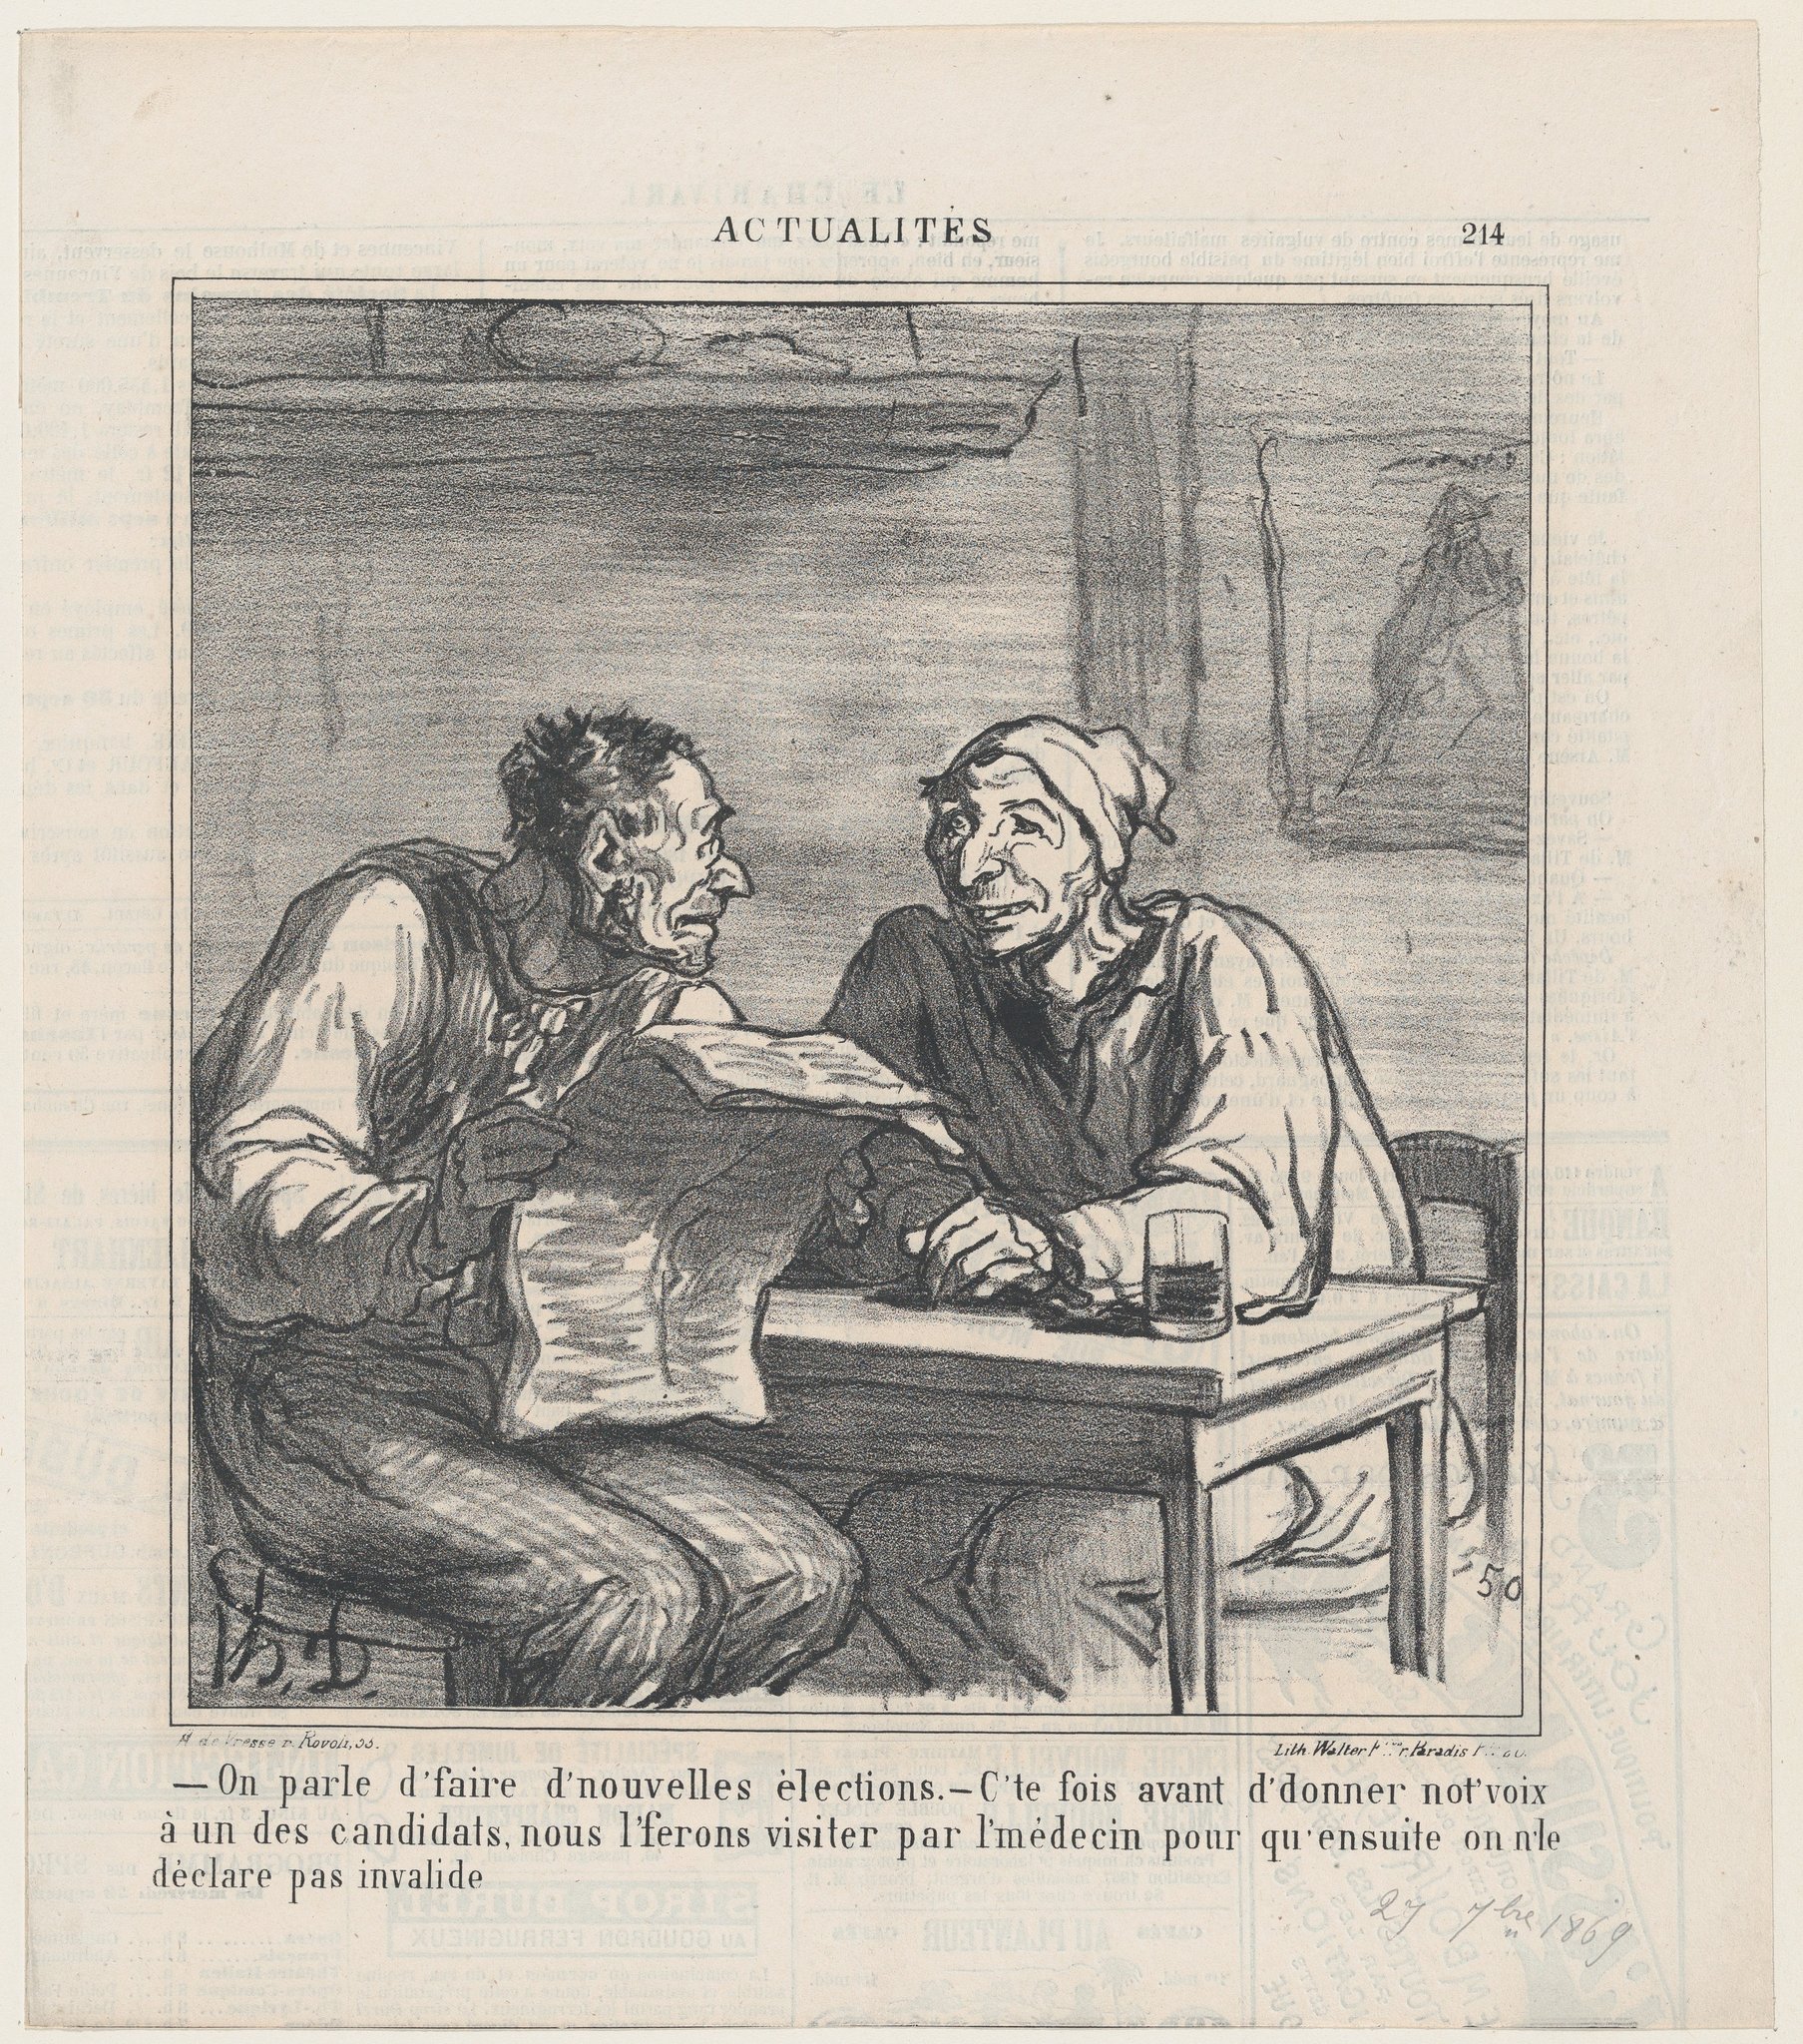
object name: print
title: –They're talking about new elections. –Before I vote for a candidate, I want him to be examined by a doctor to make sure he is not declared invalid again, from 'News of the day,' published in Le Charivari, September 27, 1869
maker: honoré daumier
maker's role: artist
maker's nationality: french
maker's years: 1808-1879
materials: paper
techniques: lithograph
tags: satire,men